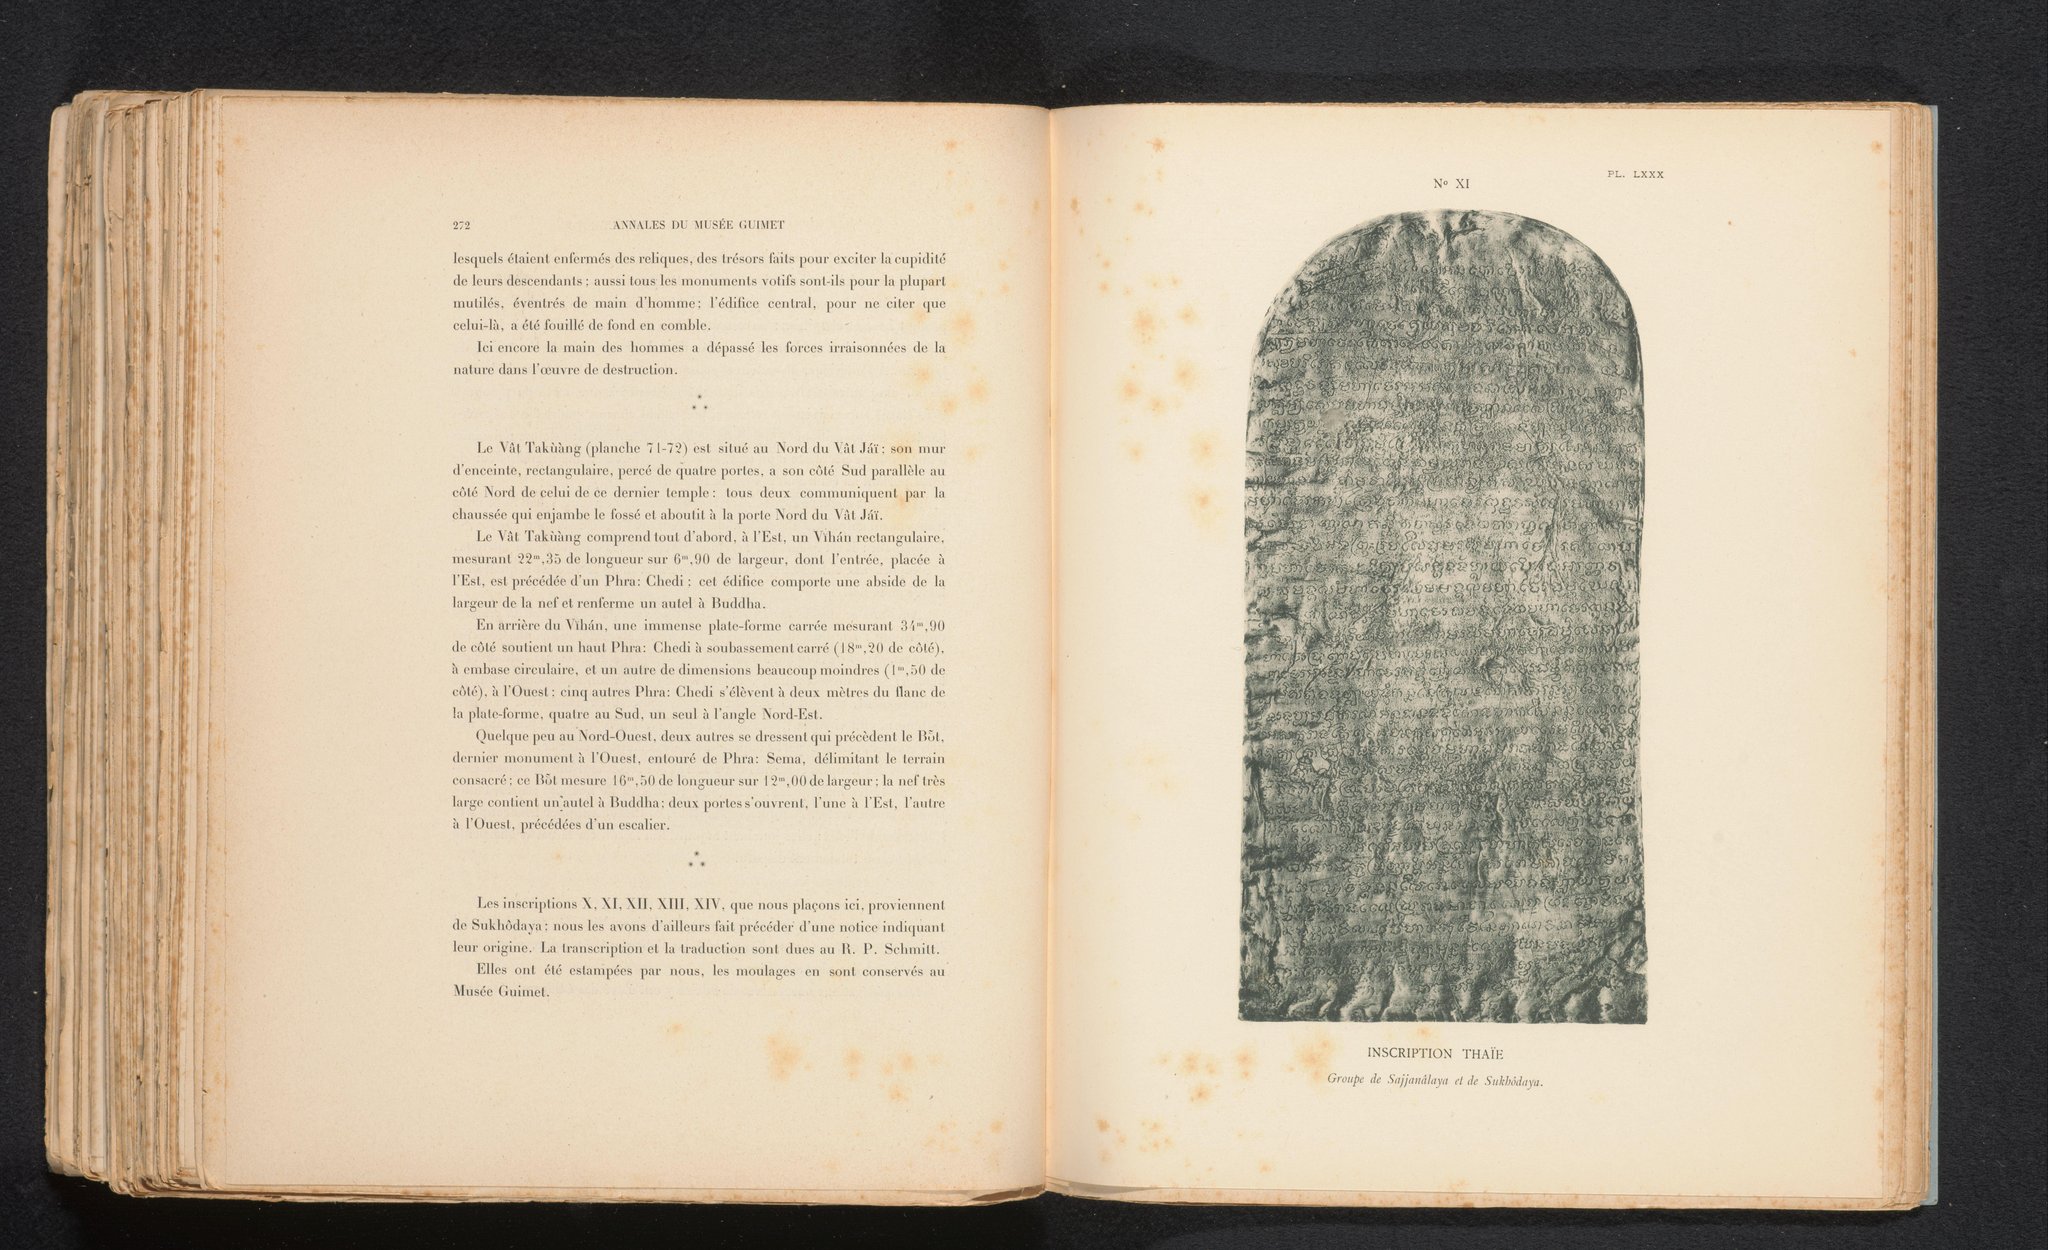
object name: photomechanical print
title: Stèle met Thaise inscriptie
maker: Anonymous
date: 1890-1895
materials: paper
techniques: photograph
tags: inscription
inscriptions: inscription: ‘Pl. LXXX’, collector's mark: ‘Société d'Emulation de l'Ain/ Bourg/ Bibliothèque’, inscription: ‘No. XI/ Groupe de Sajjanâlaya et de Sukhôdaya’